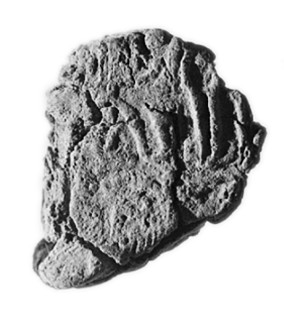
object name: sealing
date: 1981-1640 BCE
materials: mud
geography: egypt